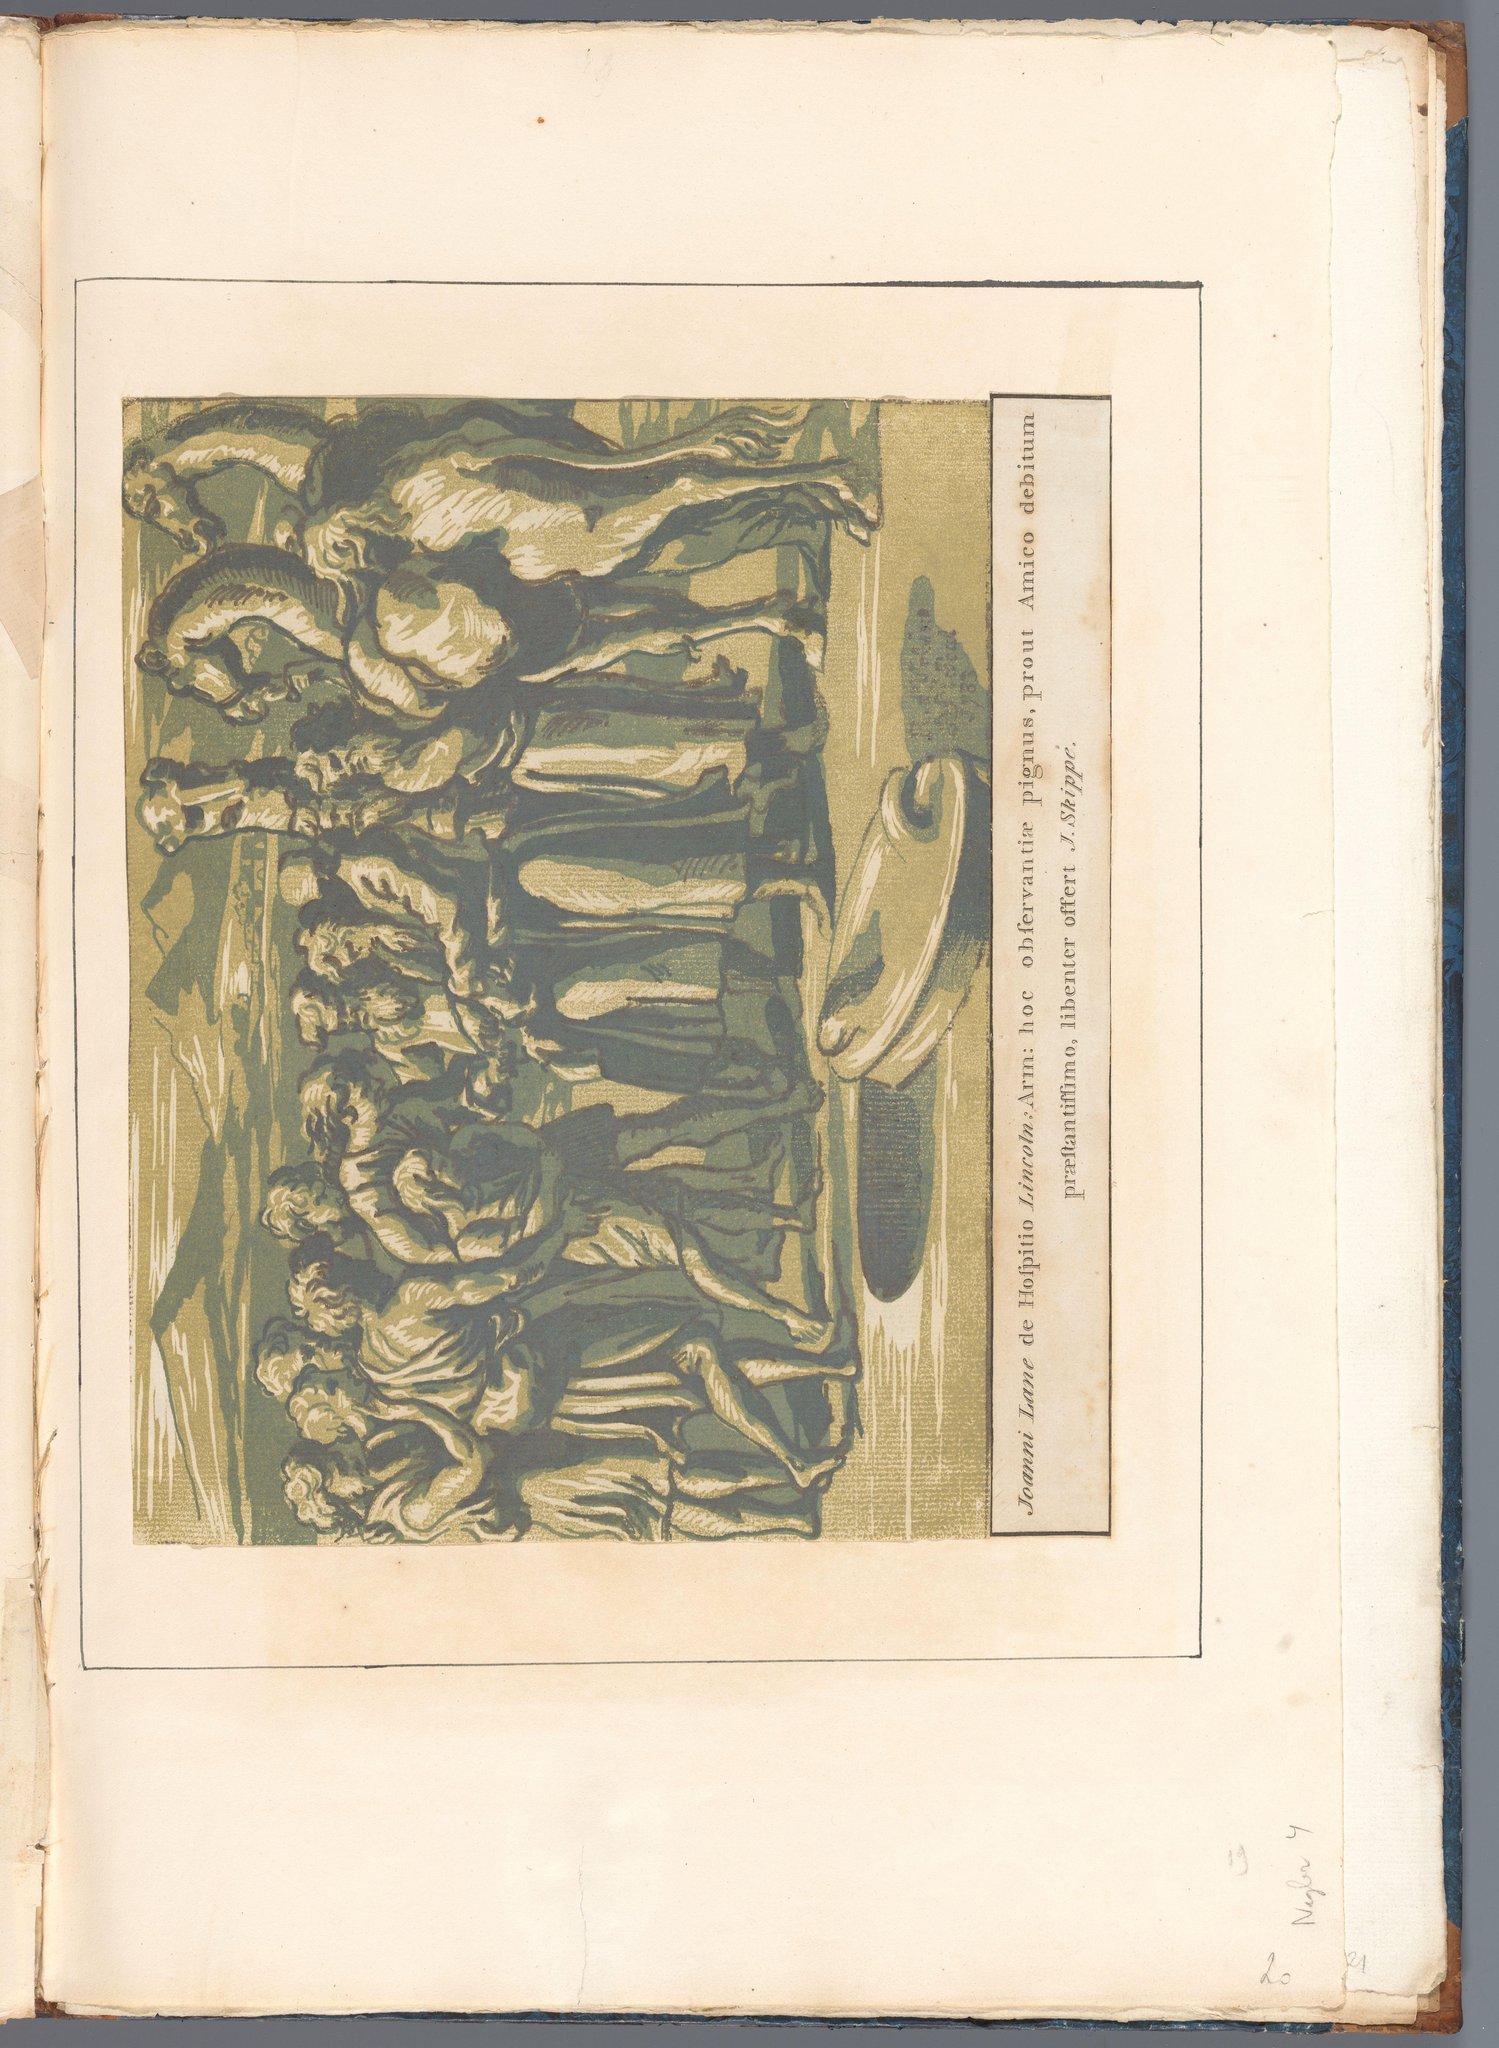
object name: print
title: Amicis suis necnon unicuique (...)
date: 1783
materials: ink, paper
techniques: woodcut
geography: england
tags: joseph is sold for twenty pieces of silver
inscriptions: date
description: Jozef door zijn broers uit de put gehaald en verkocht. Met etiket met tweeregelige tekst in het Latijn waarin vermeld de naam: John Lane. Onderdeel van een album met 26 ingeplakte clair-obscur houtsneden naar Italiaanse kunstenaars uit de zestiende eeuw.